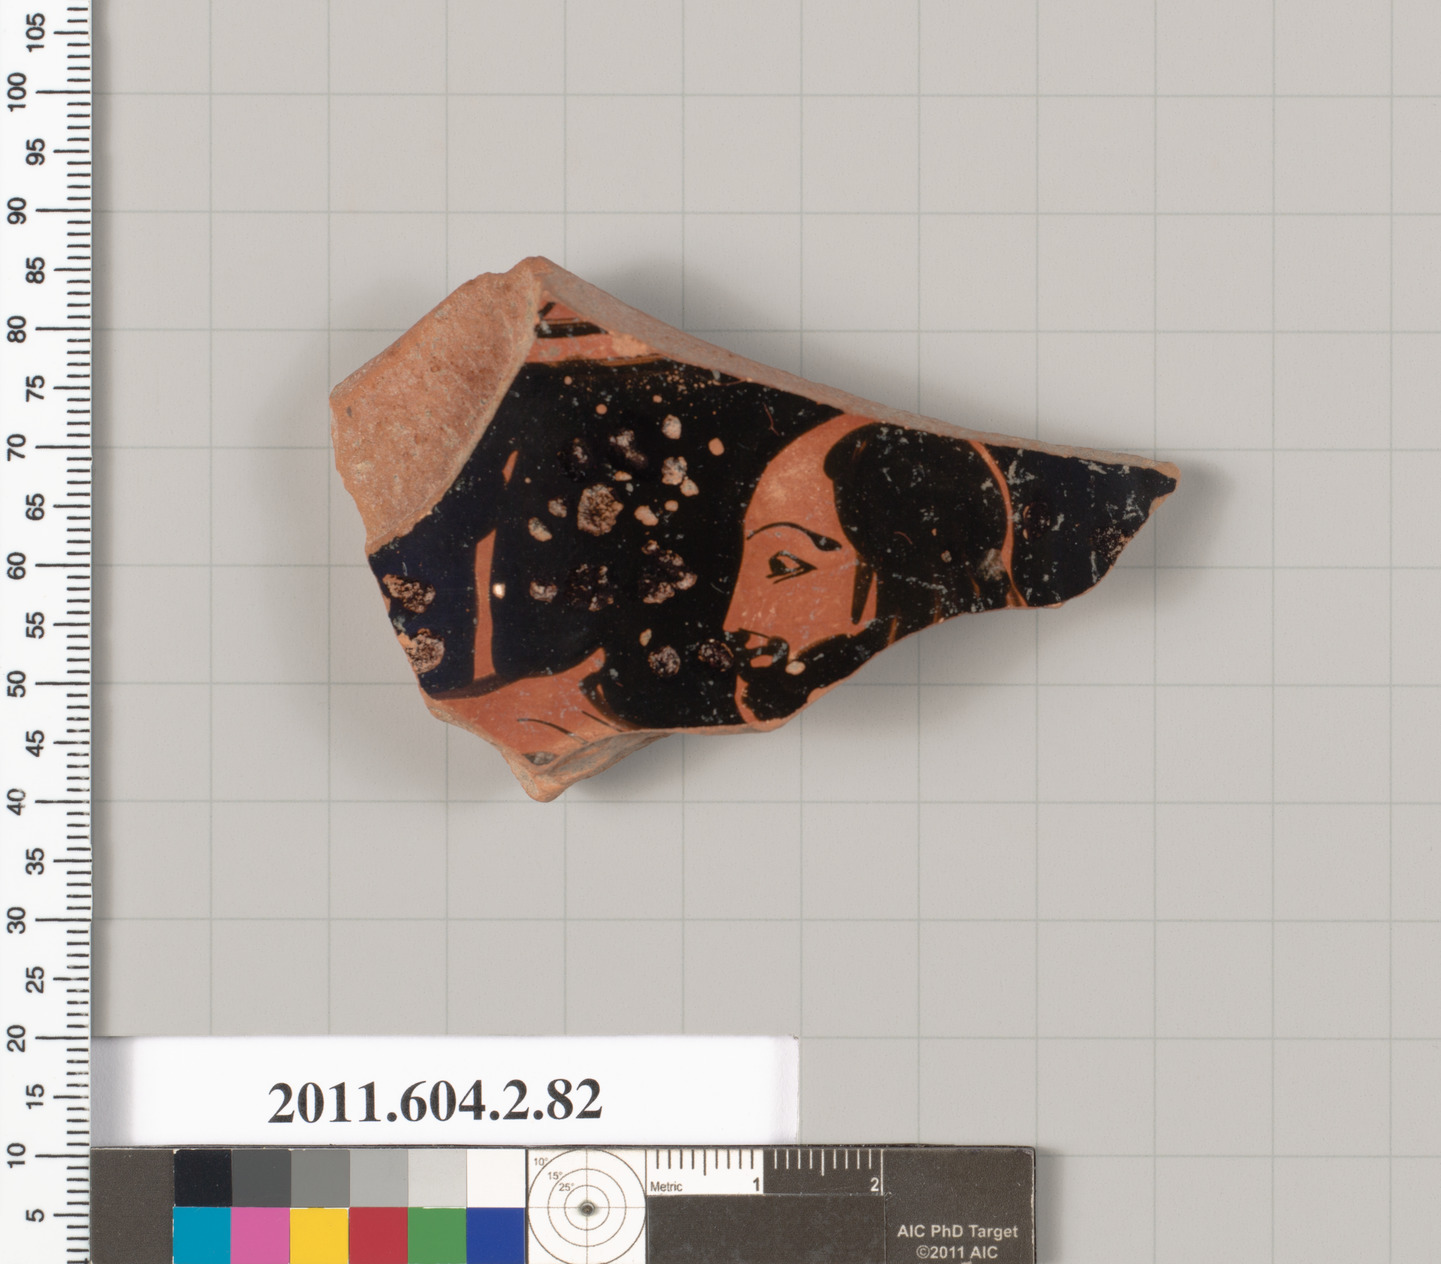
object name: pelike fragment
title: Terracotta fragment of a pelike (jar)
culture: greek, attic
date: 450-426 BCE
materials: terracotta